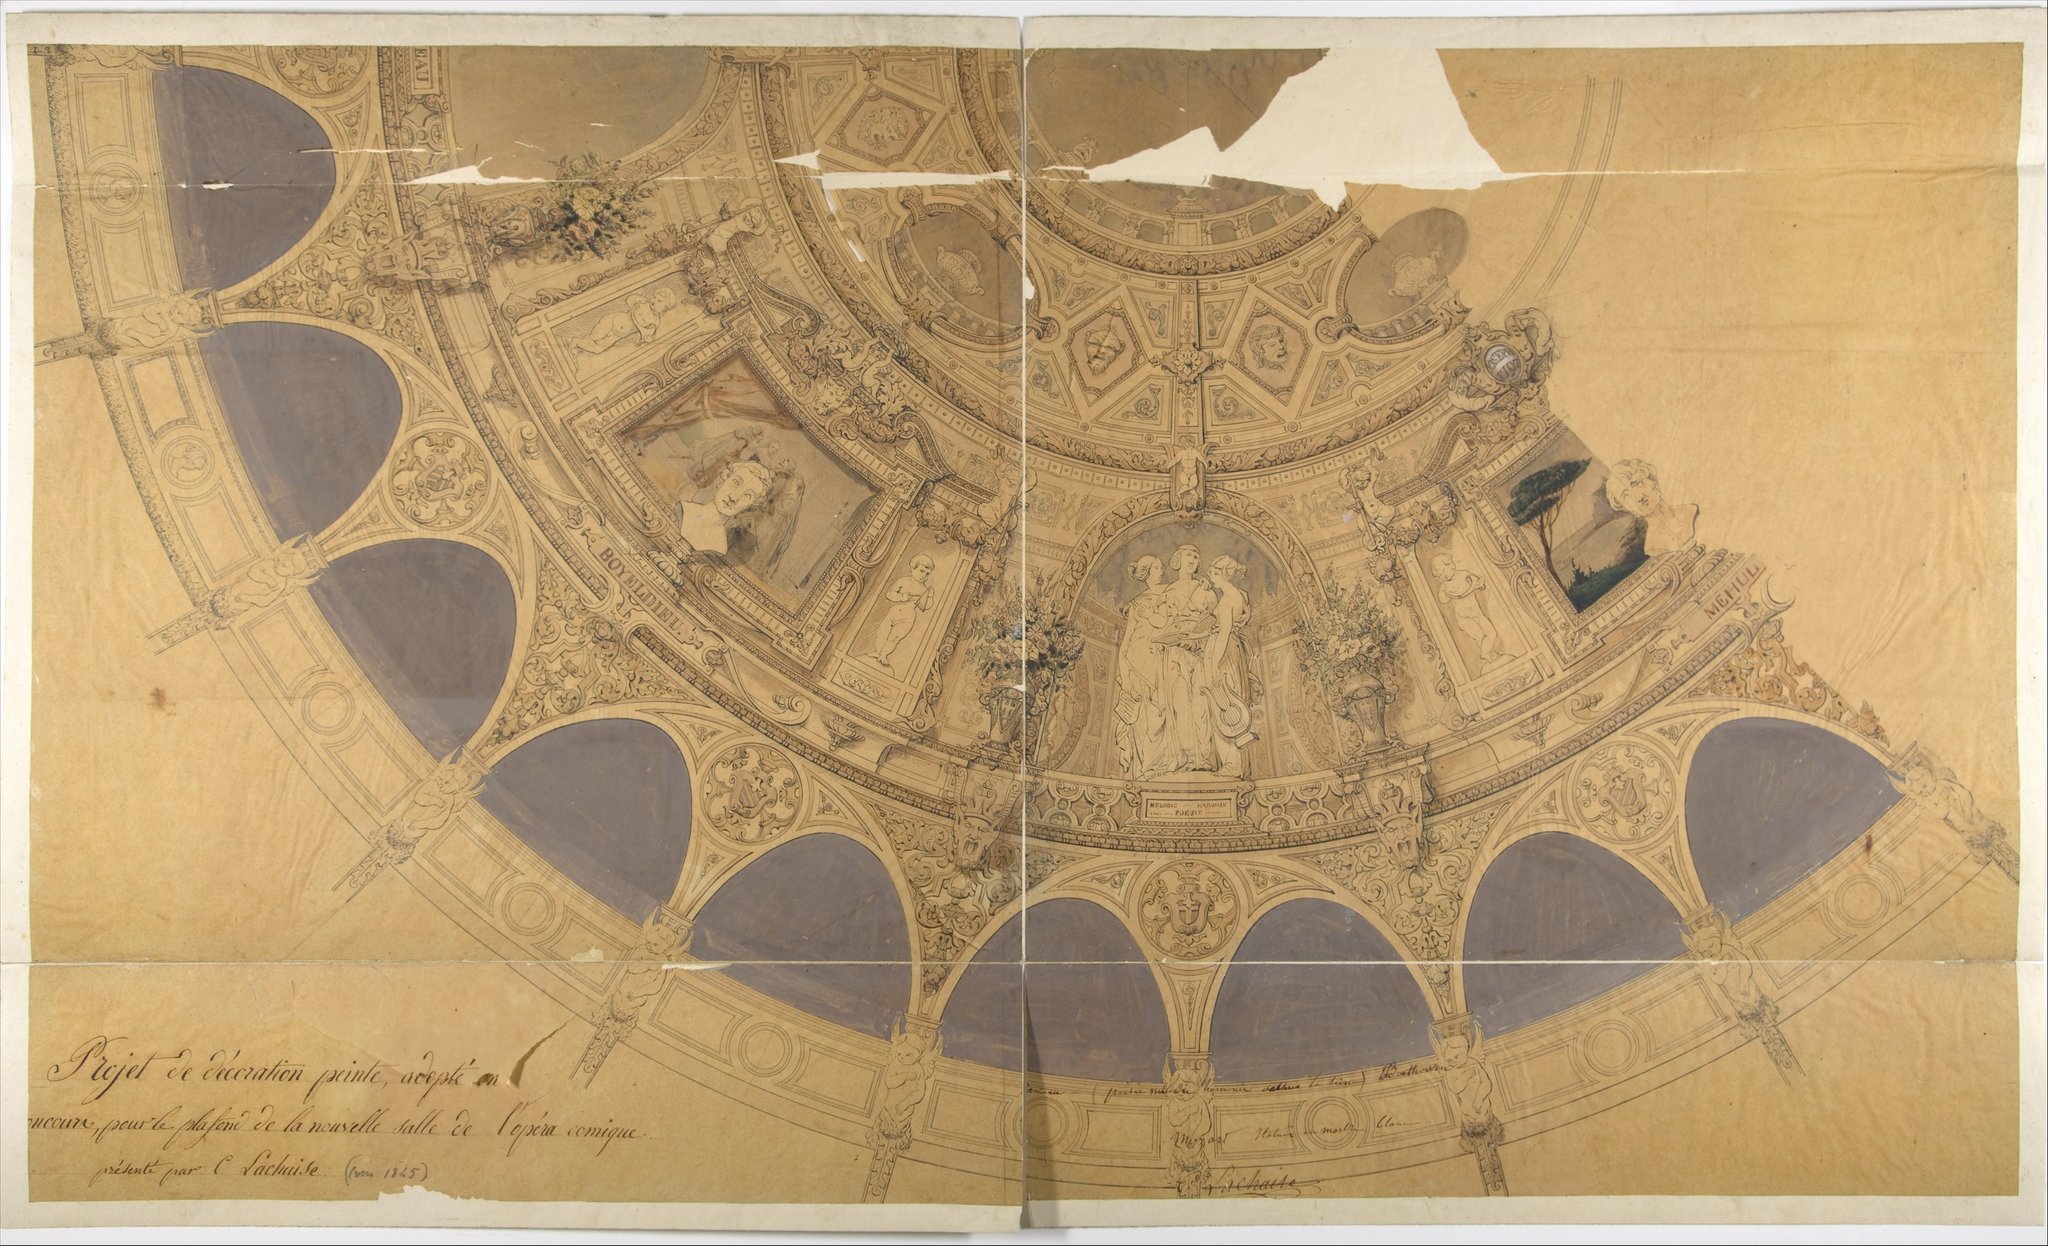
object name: drawing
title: Design for the decoration of the ceiling in the Opéra Comique, Paris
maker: jules-edmond-charles lachaise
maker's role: artist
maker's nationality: french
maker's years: 1897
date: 1845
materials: gouache, ink, watercolor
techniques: pen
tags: ceilings